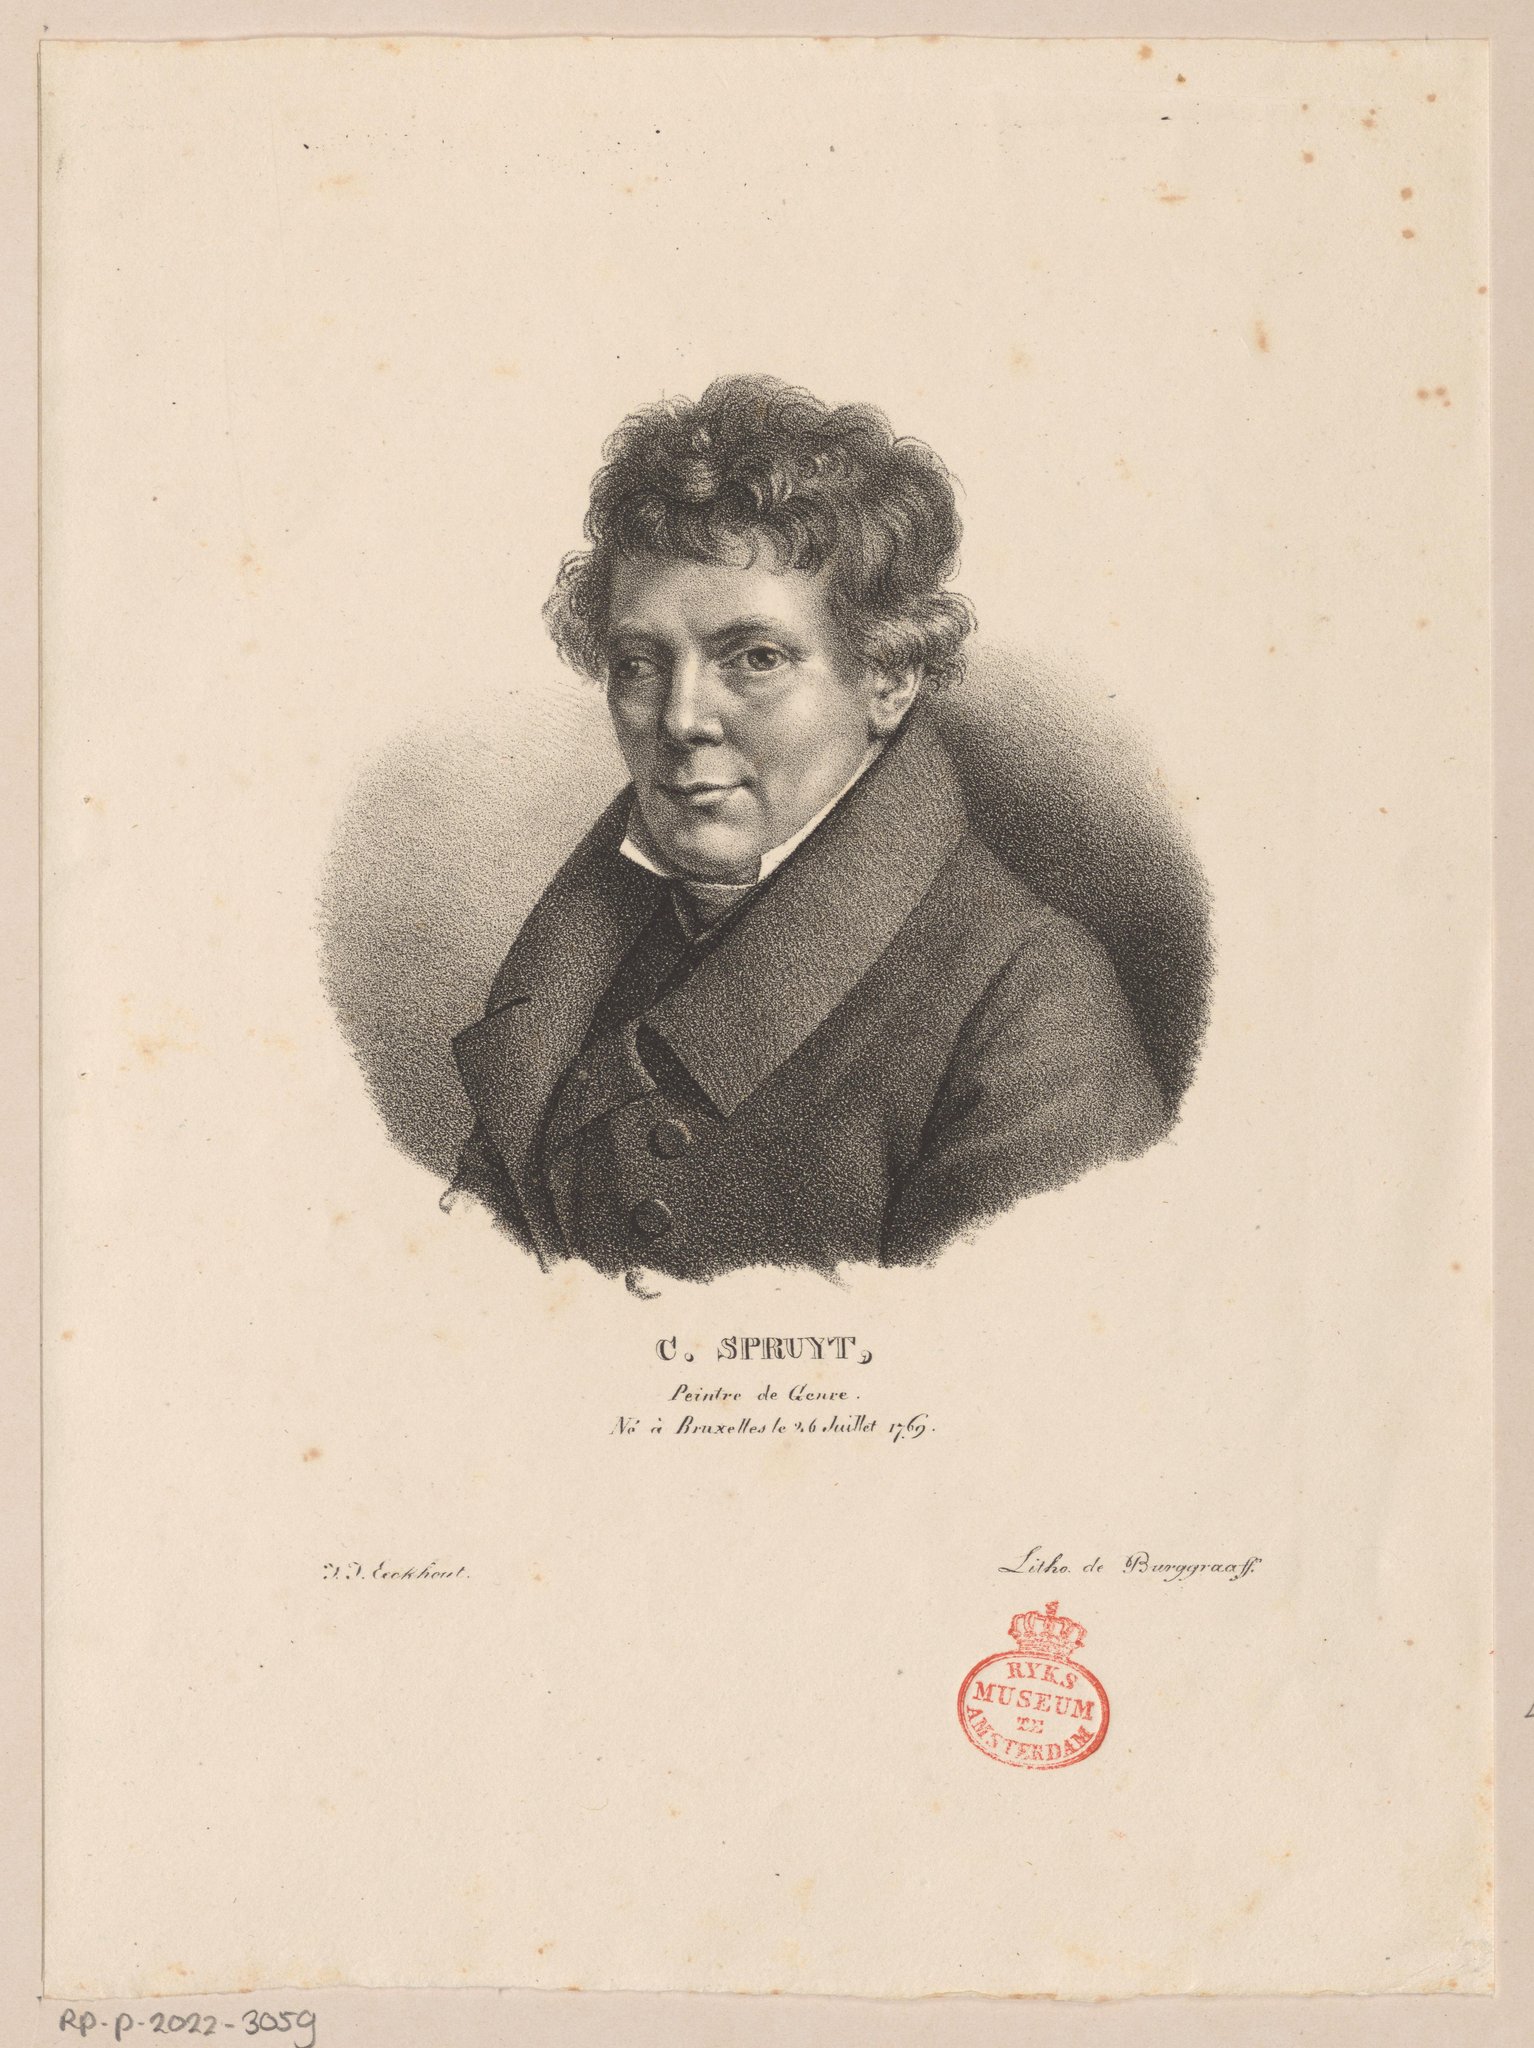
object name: print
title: Portretten van hedendaagse kunstenaars uit het Verenigd Koninkrijk der Nederlanden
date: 1822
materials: paper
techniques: lithograph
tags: brussels, print maker, charles spruyt, historical persons, portrait, self-portrait of artist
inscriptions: collector's mark: Lugt 12